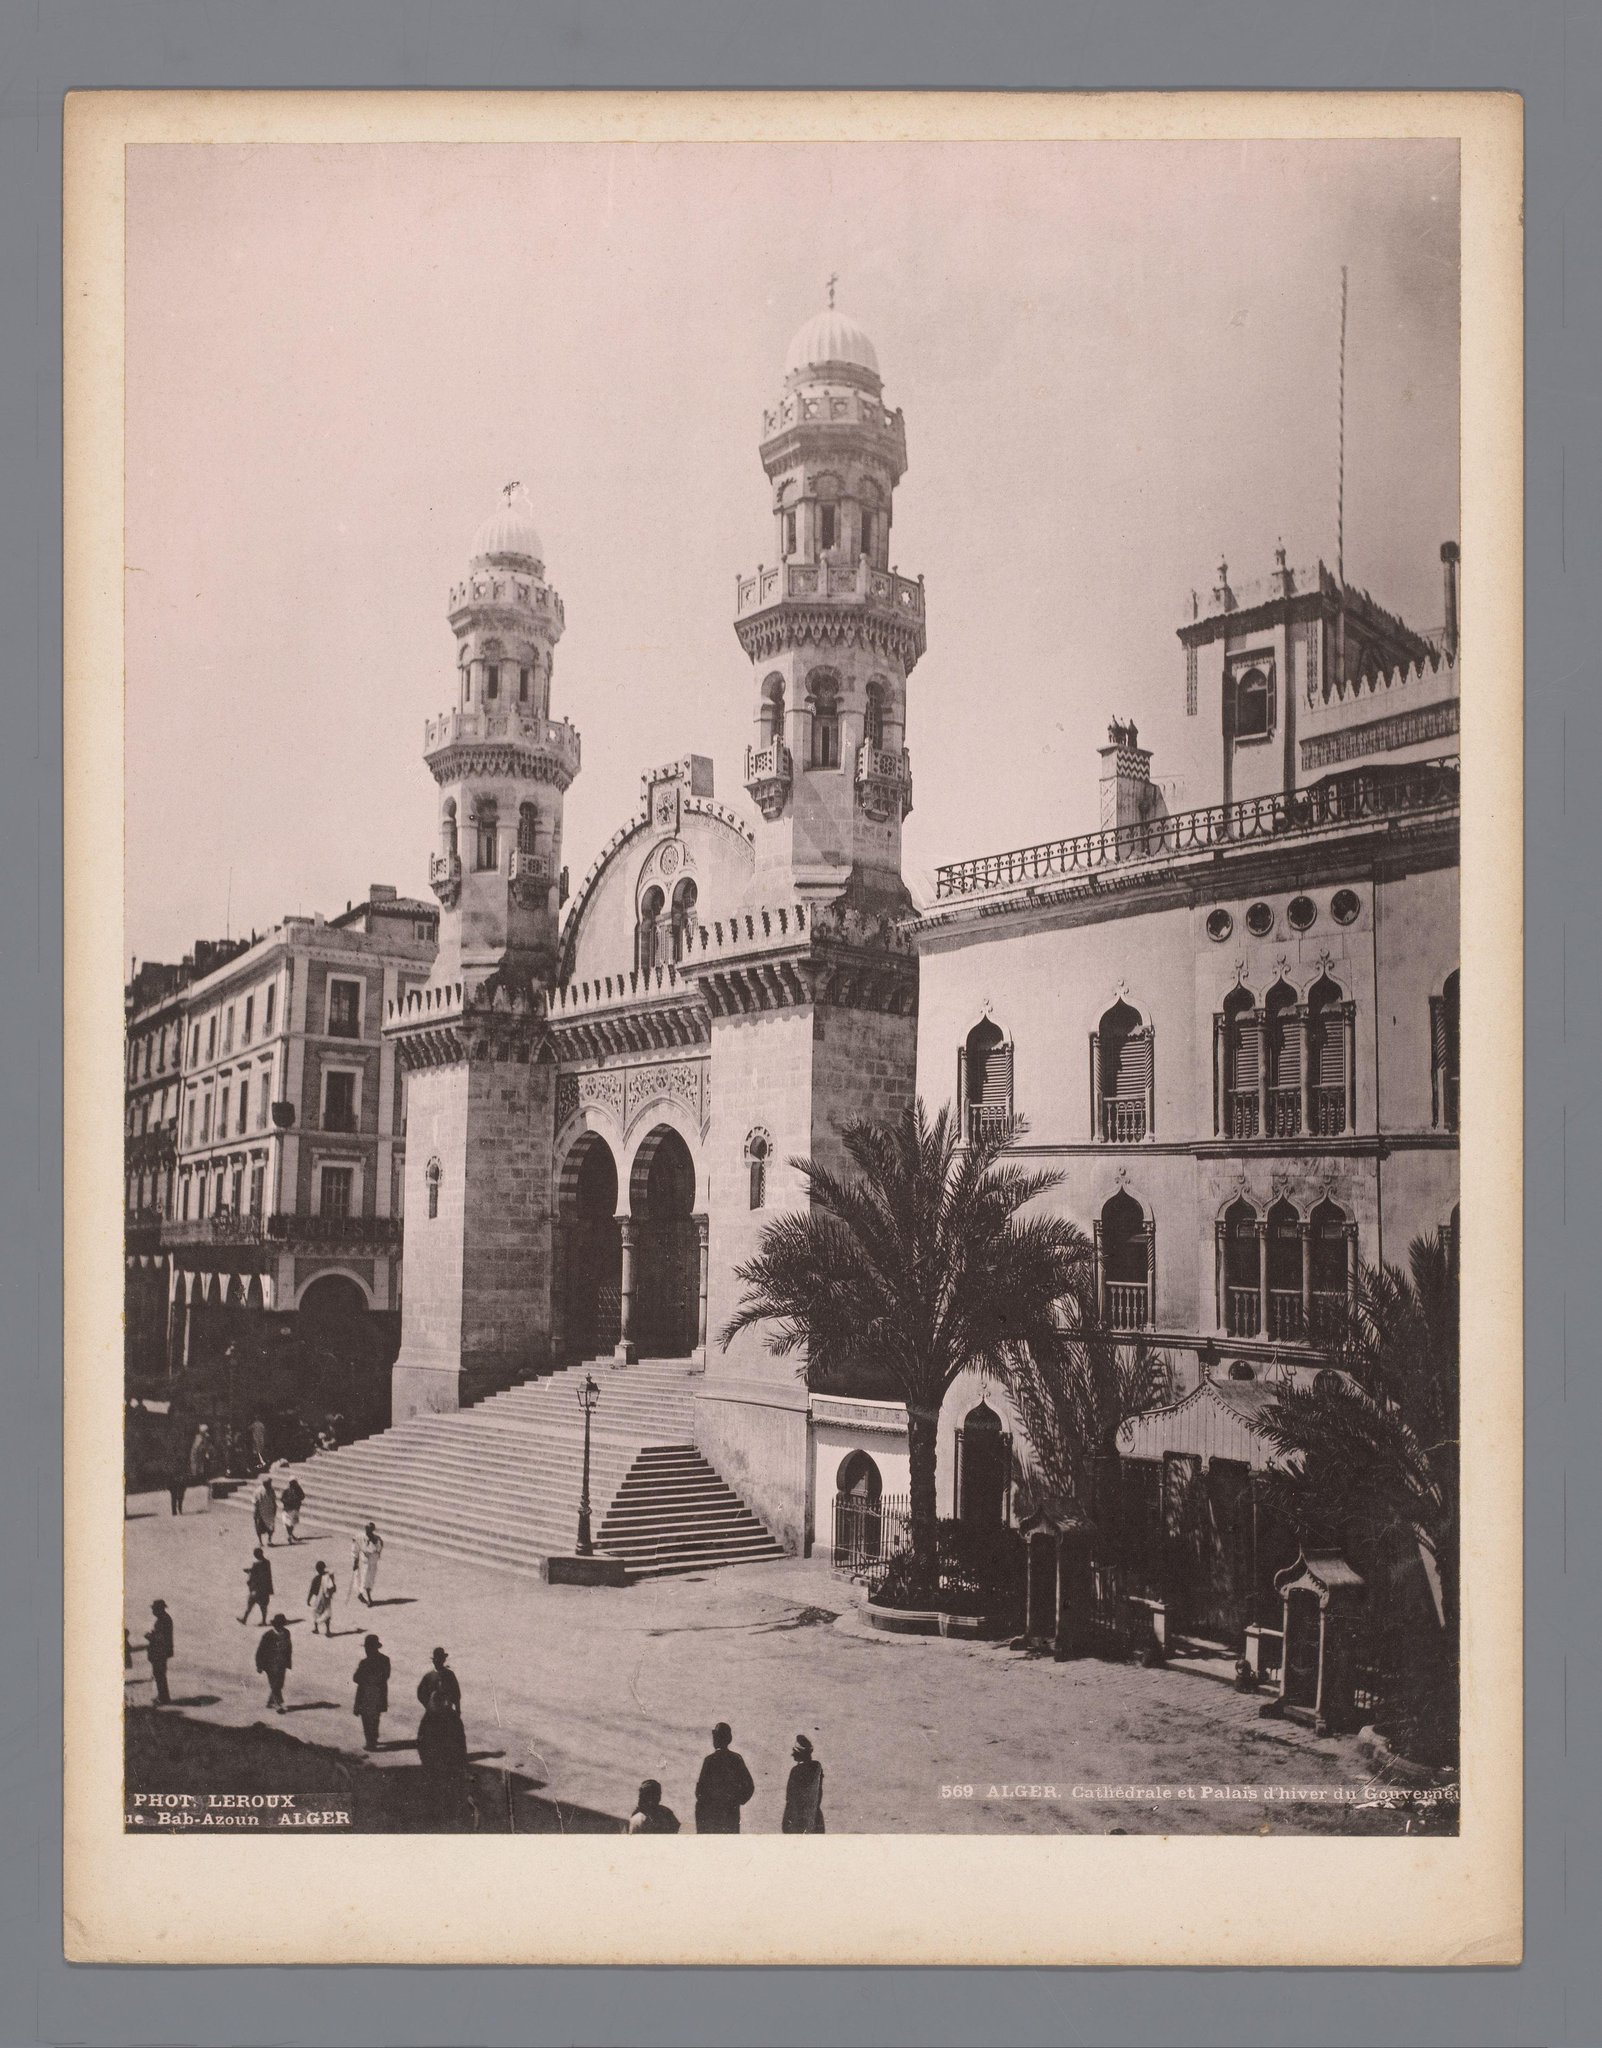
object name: photomechanical print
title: Gezicht op de Djamaa Ketchaoua en het Dar Hassan Pacha in Algiers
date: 1875-1900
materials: cardboard, paper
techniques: photograph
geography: algiers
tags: palace, temple, shrine ~ islam, mohammedanism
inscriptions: number: ‘569’, address: ‘[...]ue Bab-Azoun ALGER’